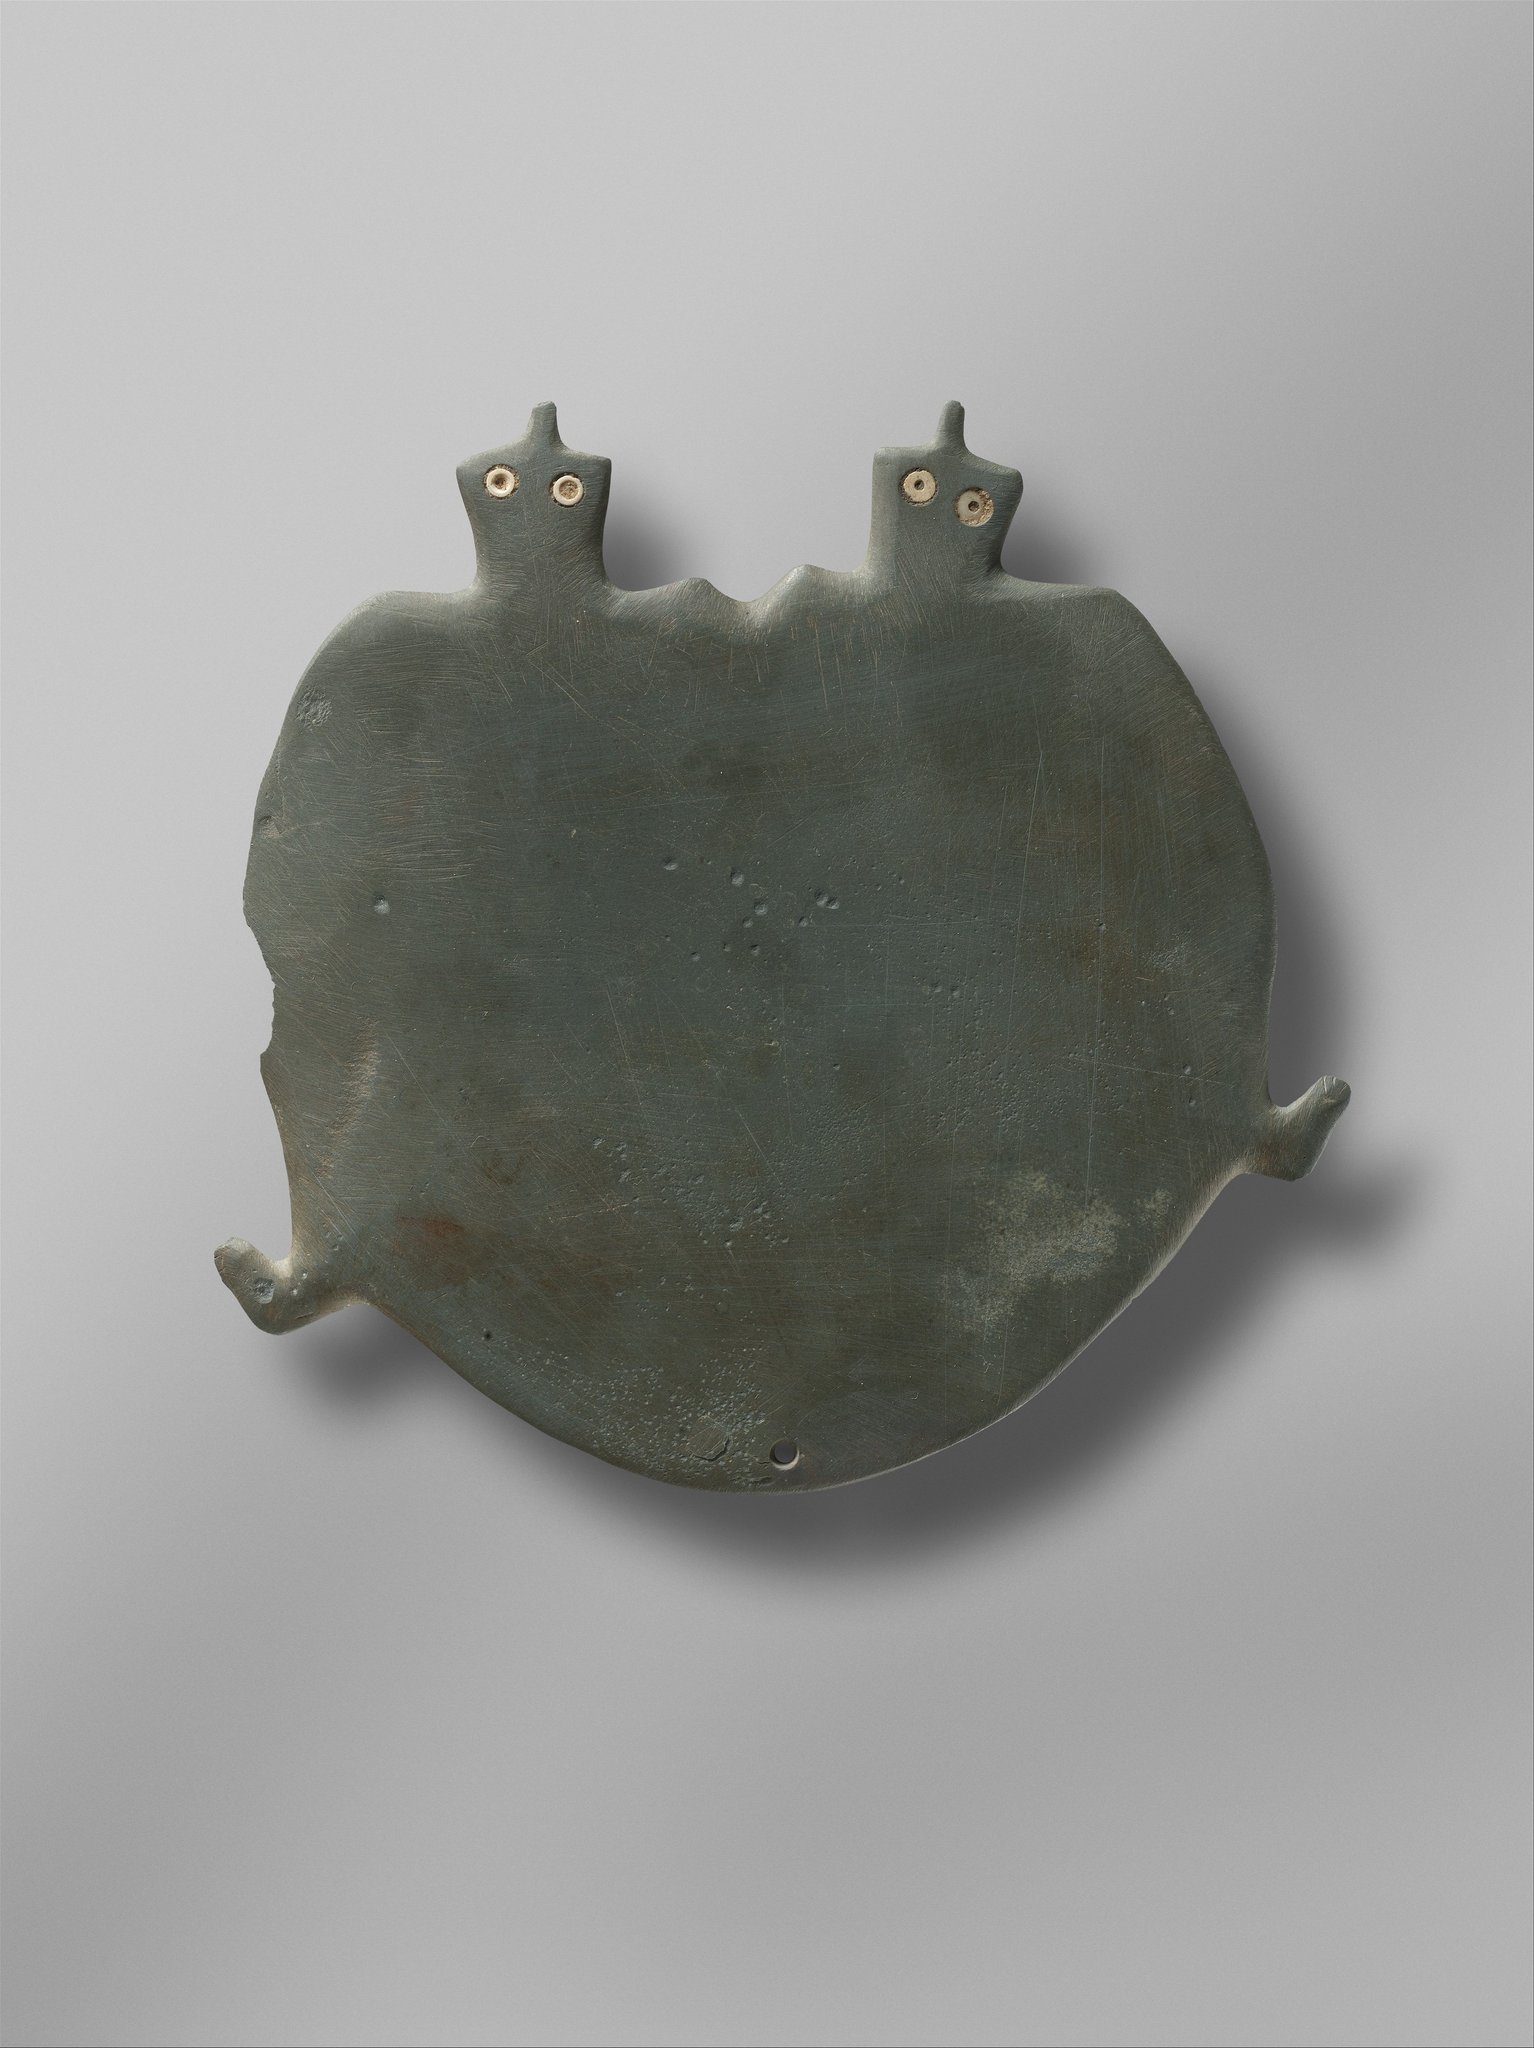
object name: palette, mud turtle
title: Palette Depicting a Pair of Mud Turtles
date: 3650-3500 BCE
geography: egypt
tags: turtles